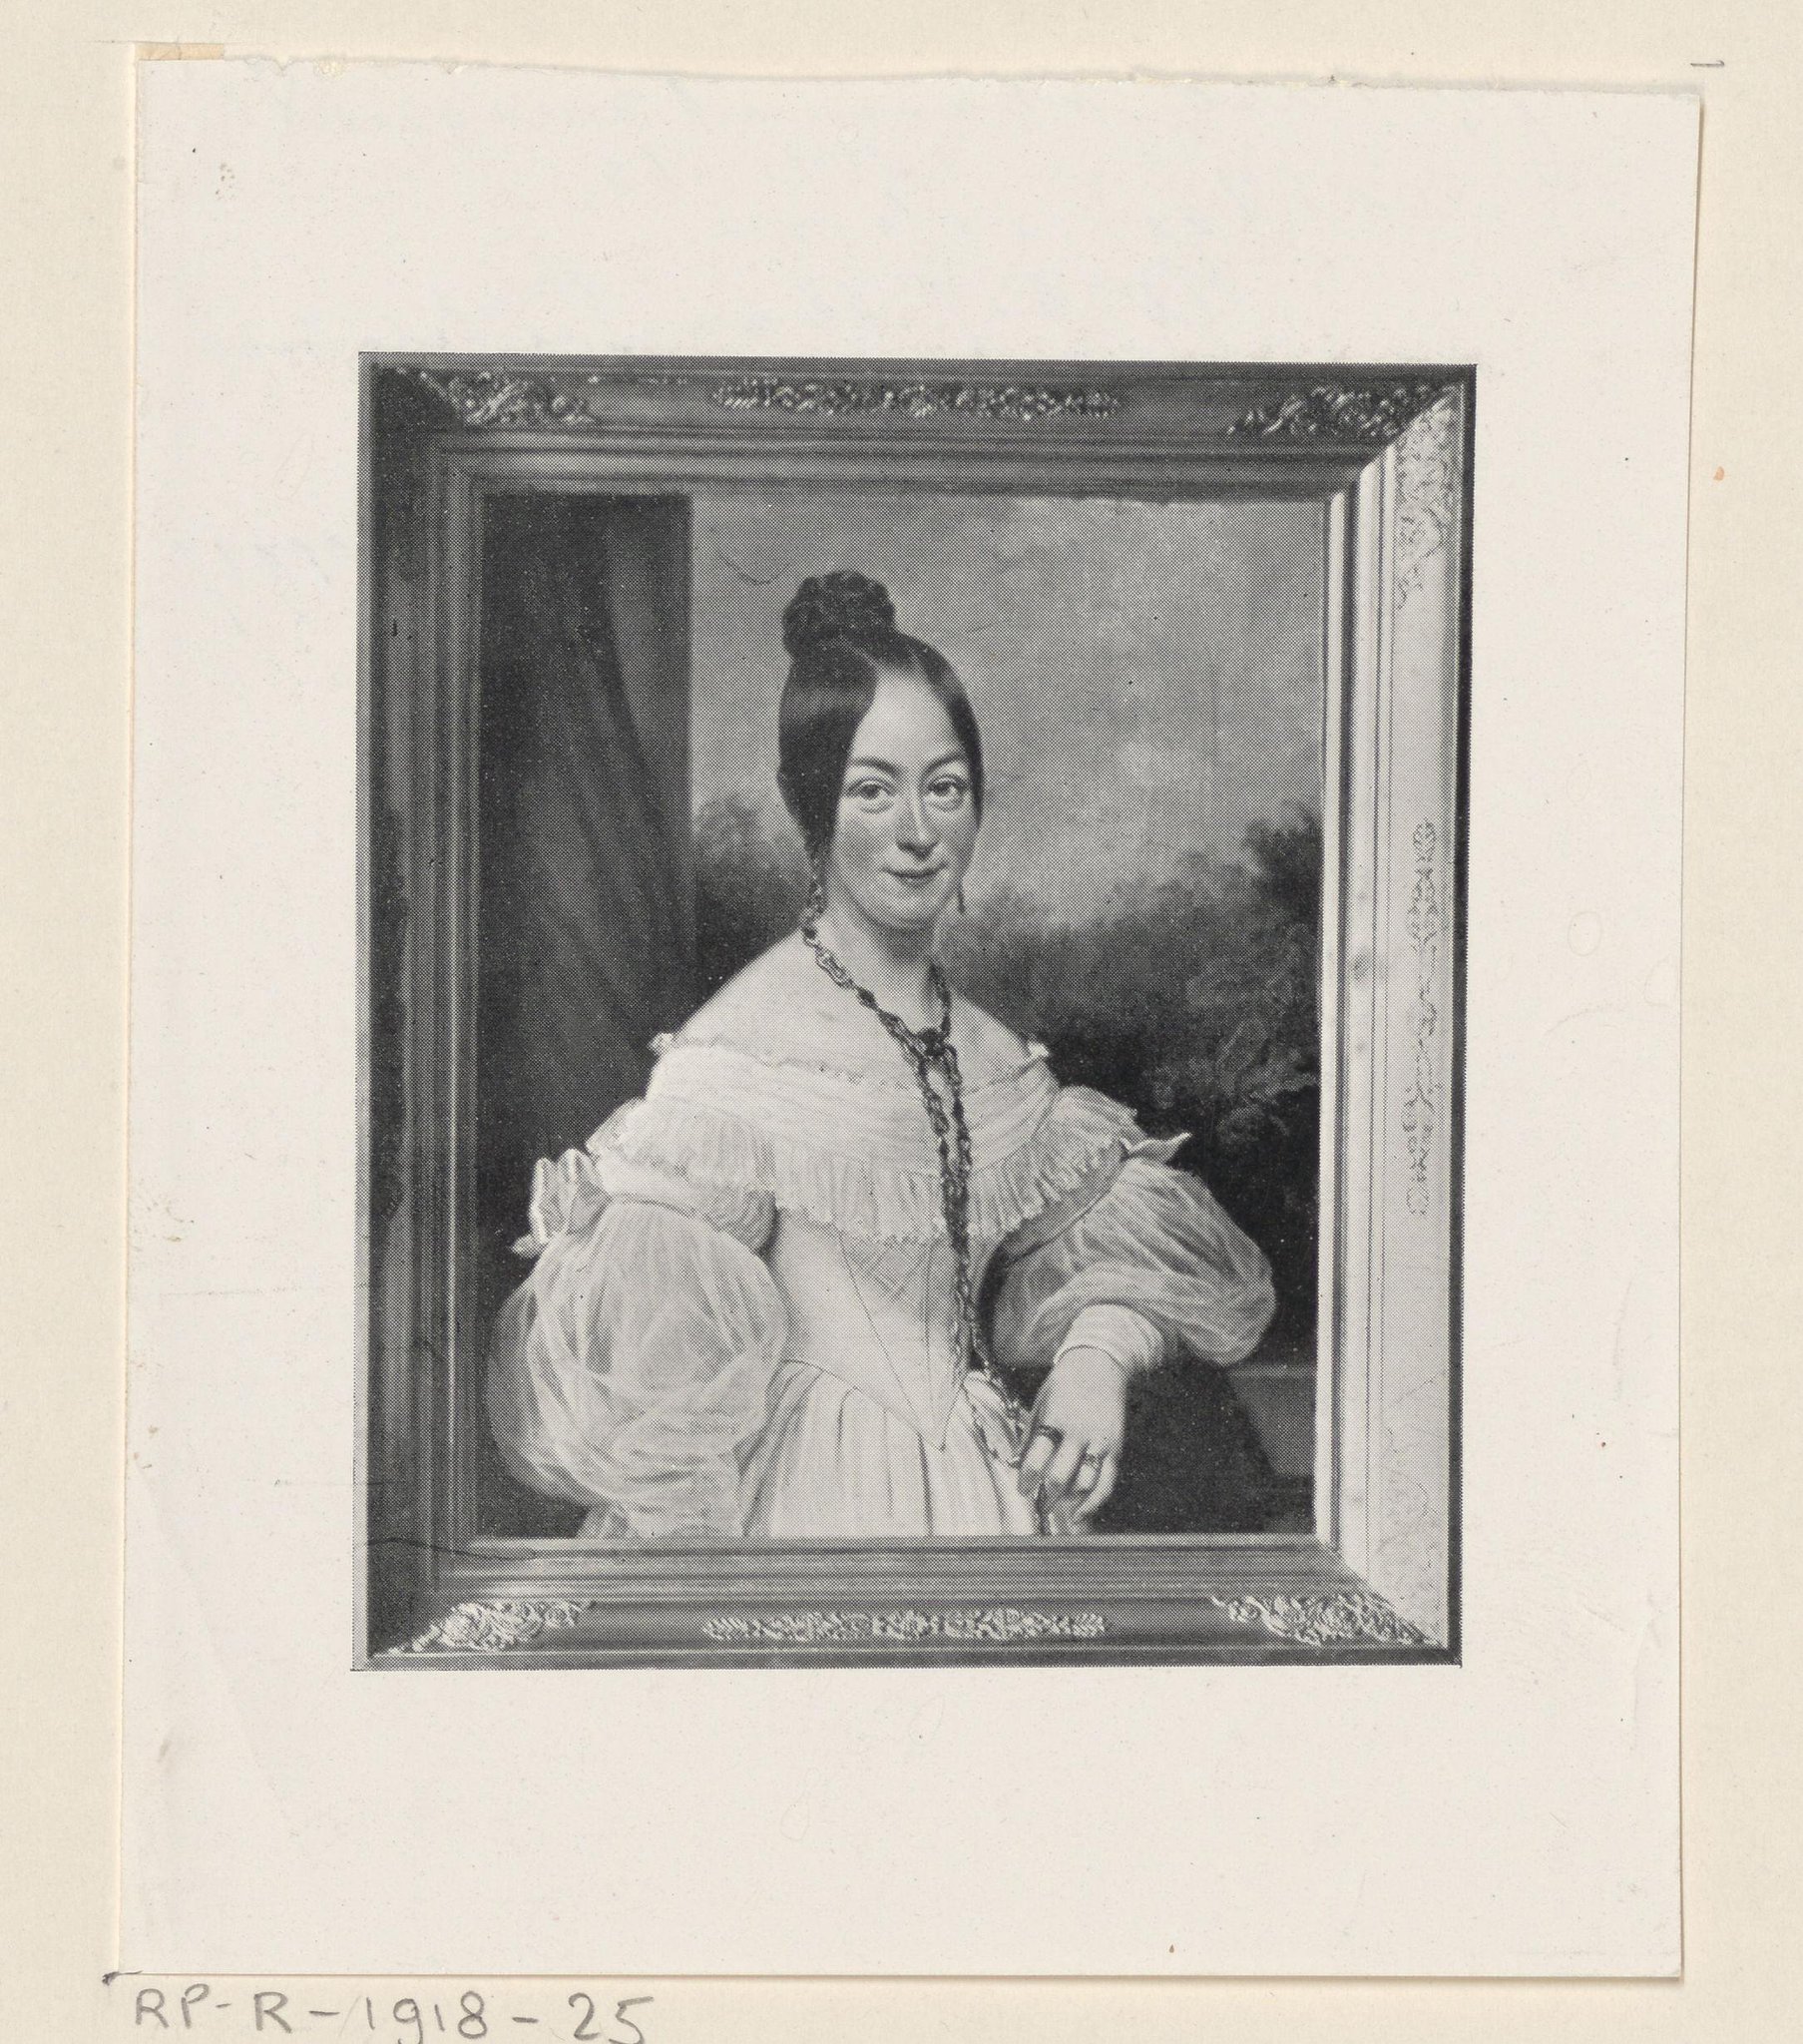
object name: reproduction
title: Portret van Gijsberta Johanna Bousquet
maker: Anonymous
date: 1882-1970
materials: paper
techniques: autotype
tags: historical persons - bb - woman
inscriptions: collector's mark: Lugt 2228